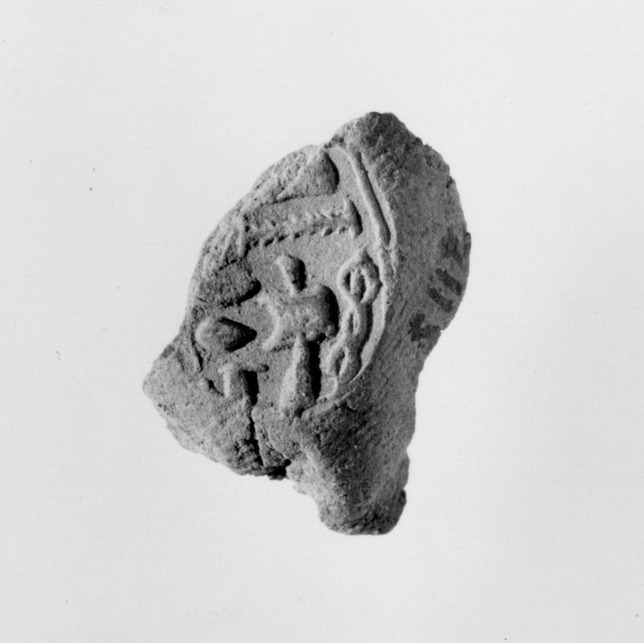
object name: sealing, amun re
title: Document Sealing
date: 1390-1352 BCE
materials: mud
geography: egypt